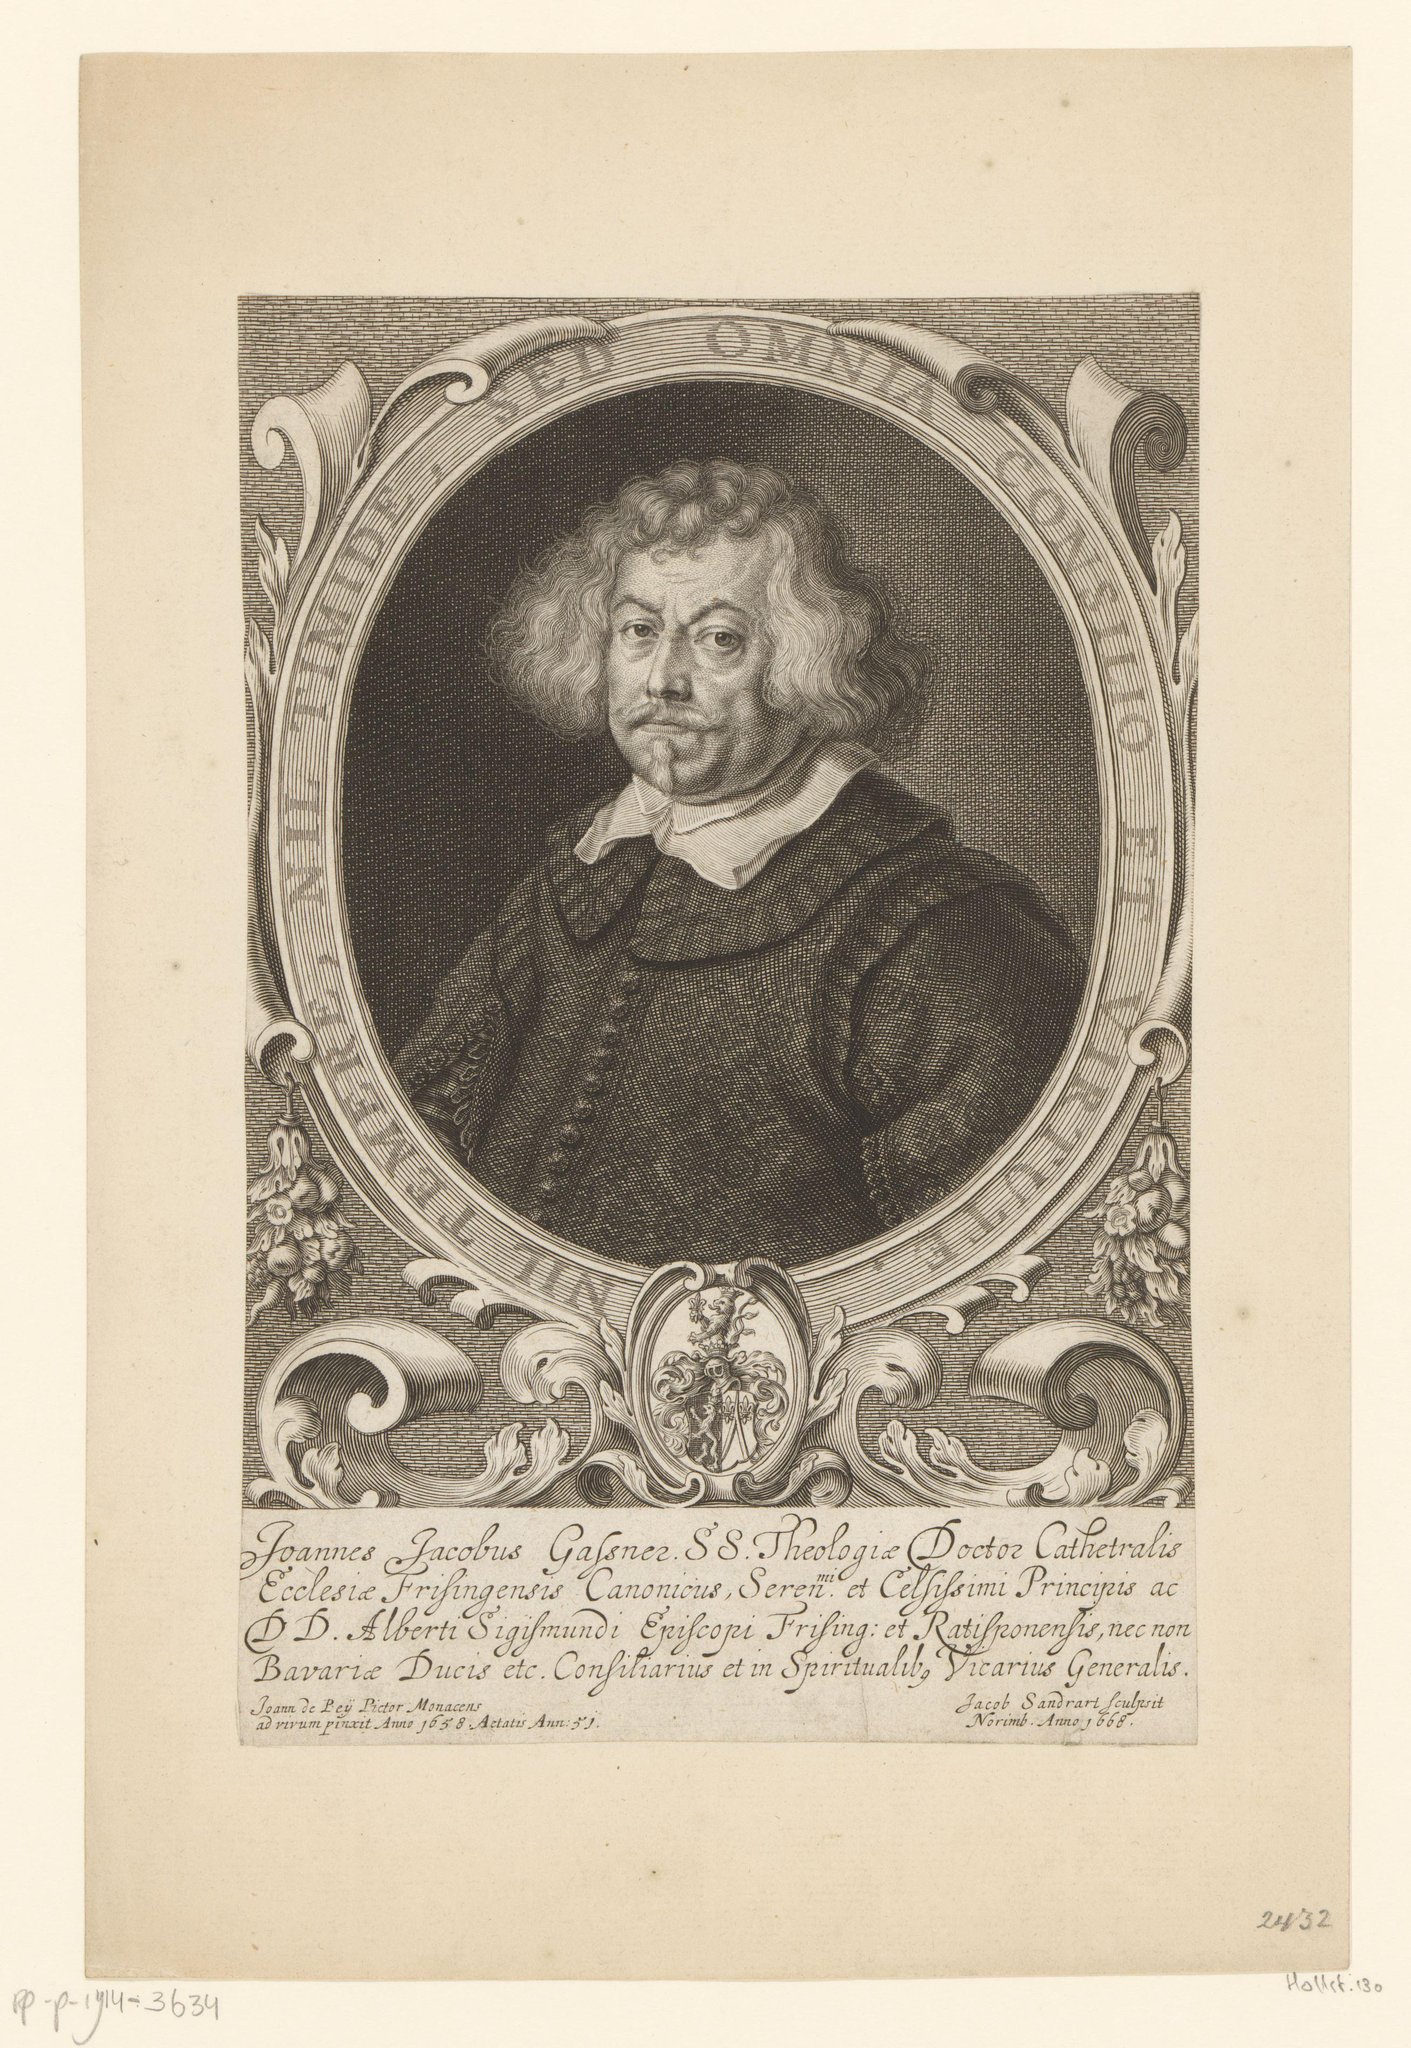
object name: print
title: Portret van Johann Jacob Gassner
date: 1668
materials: paper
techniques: engraving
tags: historical persons, armorial bearing, heraldry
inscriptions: collector's mark: Lugt 2228